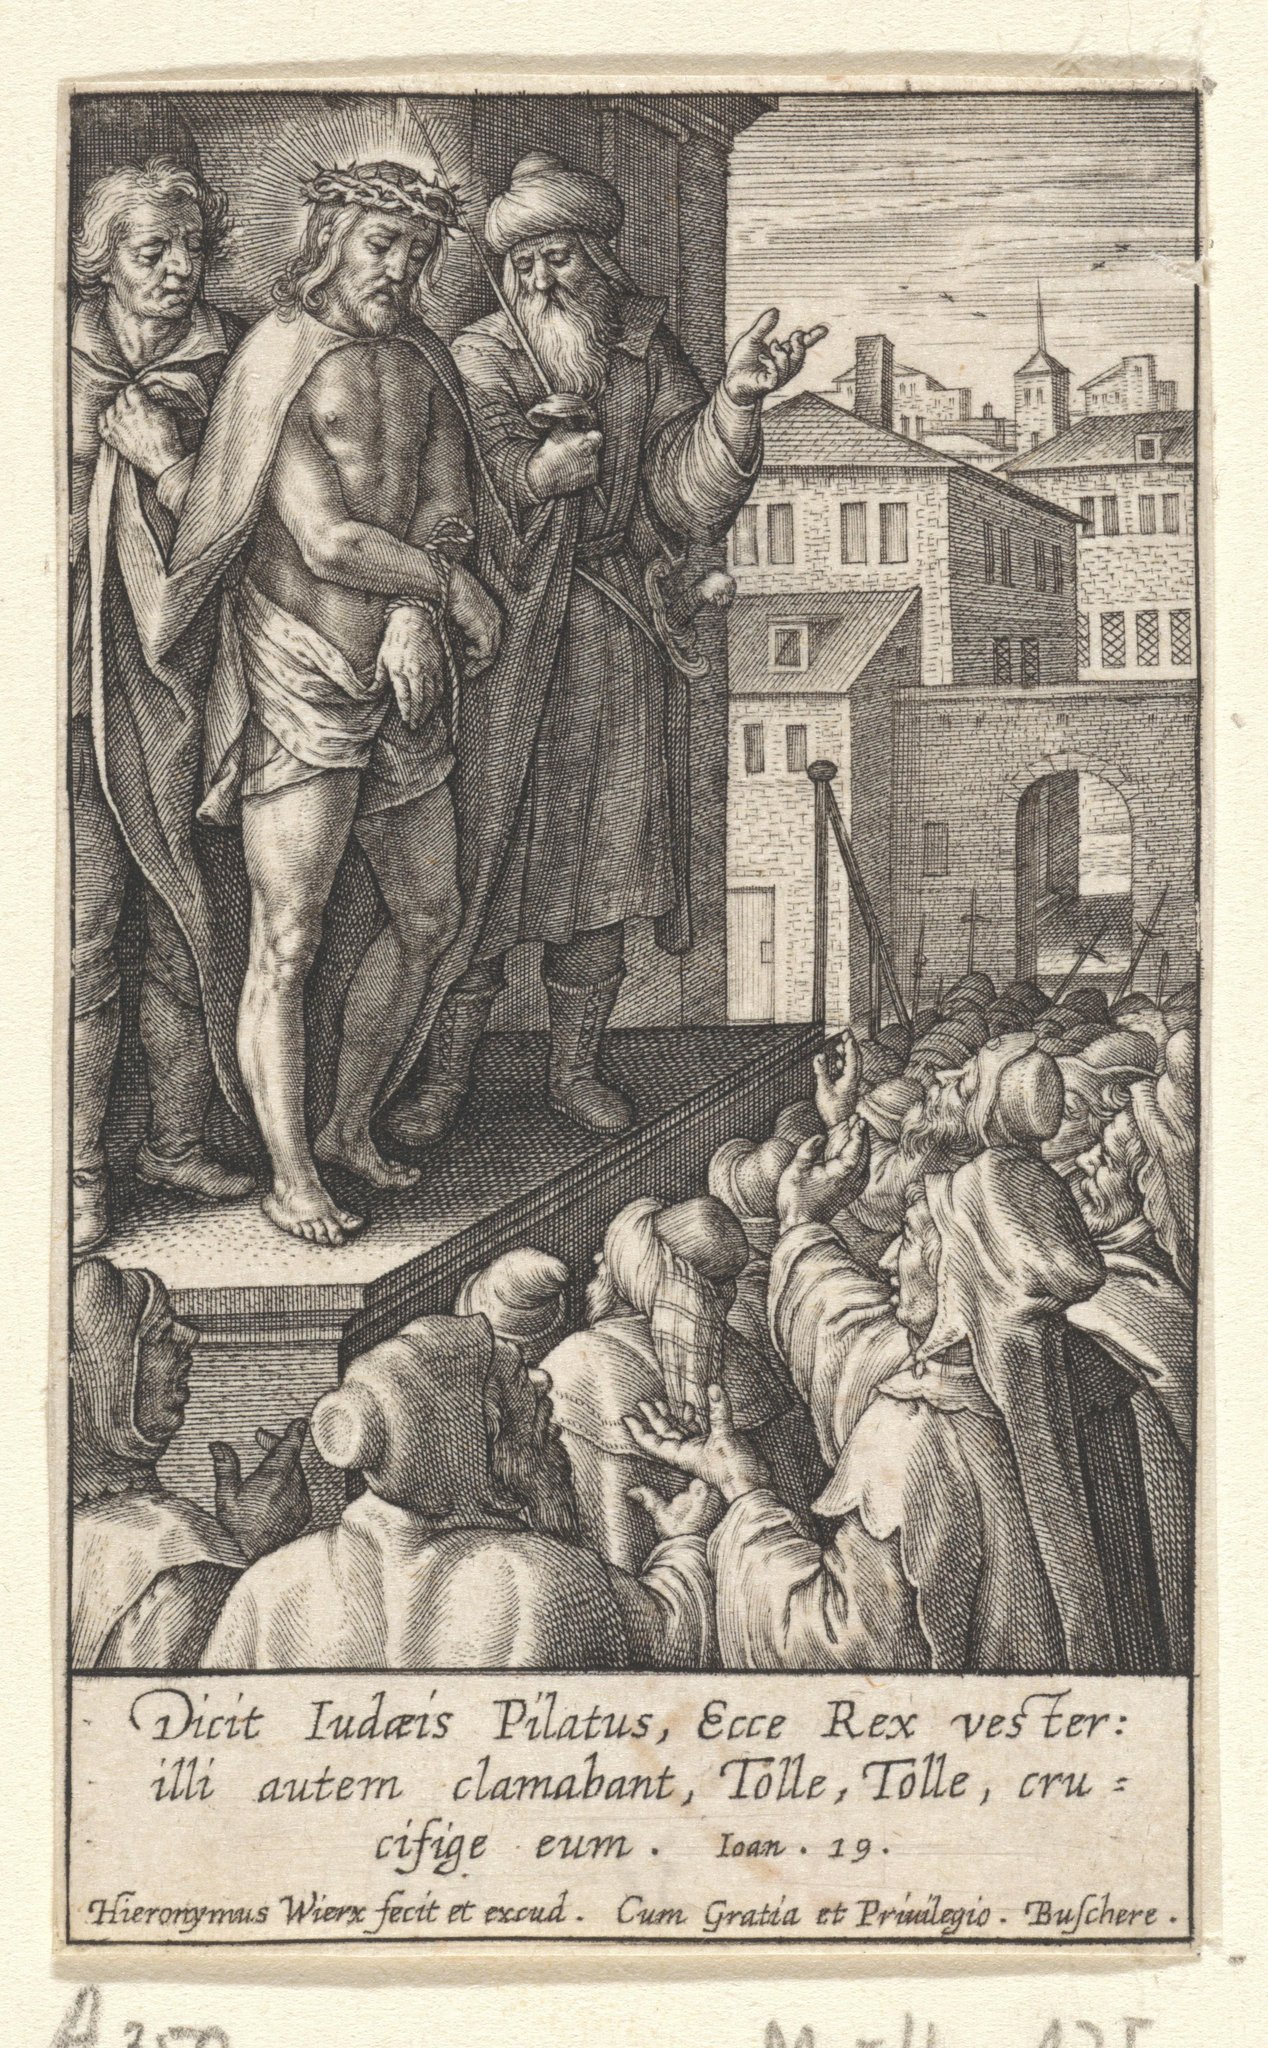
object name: print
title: Passio Domini Nostri Iesv Christi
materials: paper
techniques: engraving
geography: antwerp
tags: pilate showing christ to the people, 'ostentatio christi', 'ecce homo' (john 19:4-6)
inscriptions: number: ‘38 - 63’, collector's mark: Lugt 240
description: Pontius Pilatus toont de geboeide Christus na zijn geseling aan het Joodse volk. De mensen roepen om zijn kruisiging. In de marge een drieregelig Bijbelcitaat uit Joh. 19 in het Latijn.